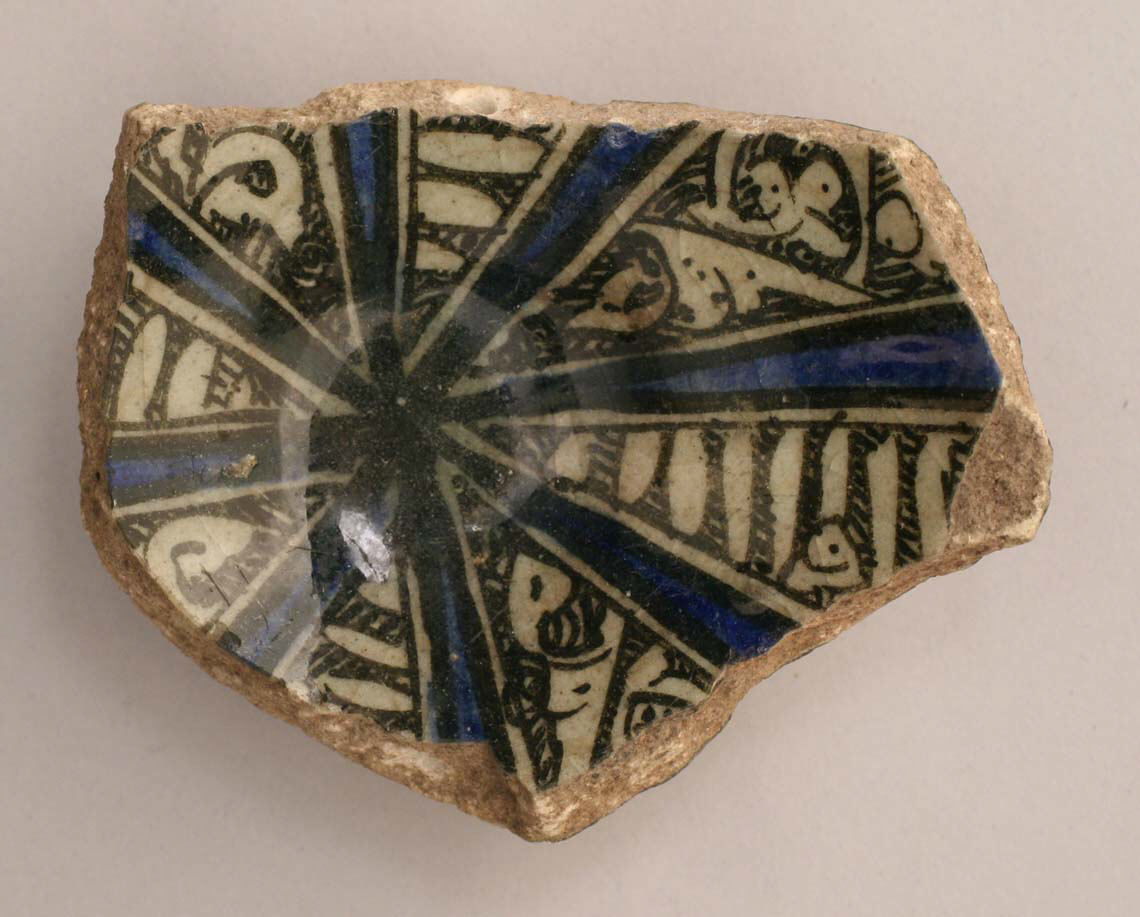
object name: fragment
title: Ceramic Fragment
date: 1301-1400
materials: glaze, stonepaste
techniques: painting, polychrome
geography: syria